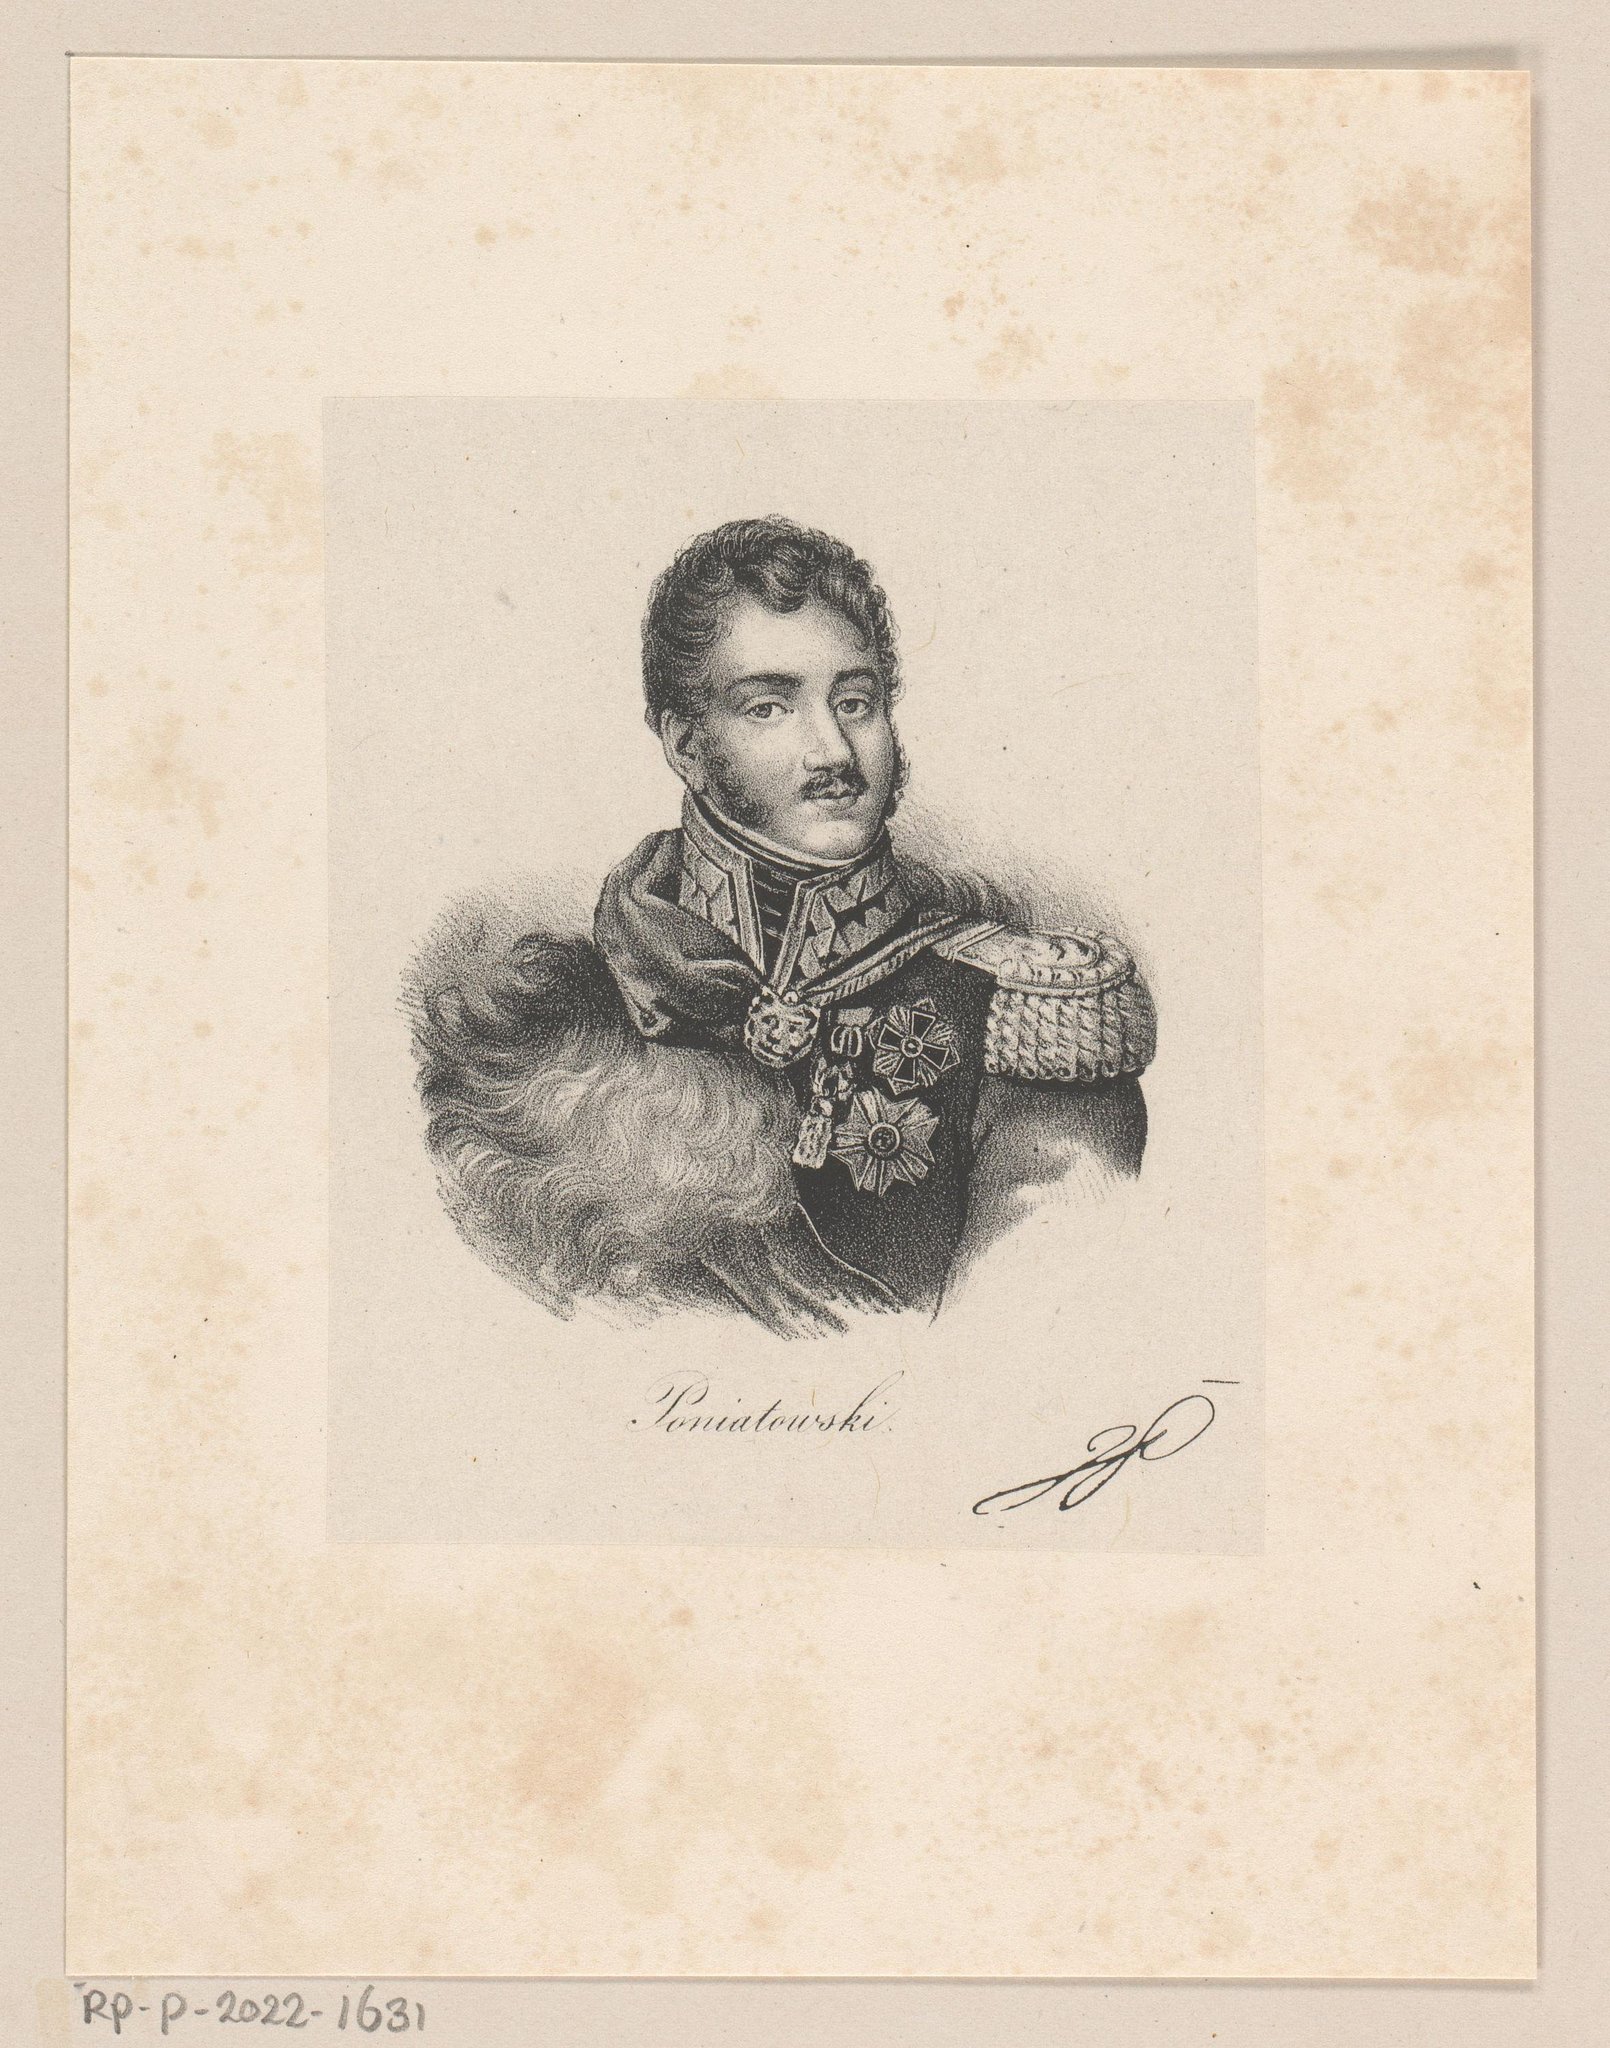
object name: print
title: Portret van Józef Poniatowski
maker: Anonymous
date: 1803-1850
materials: paper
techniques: lithograph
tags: commander-in-chief, general, marshal, historical persons